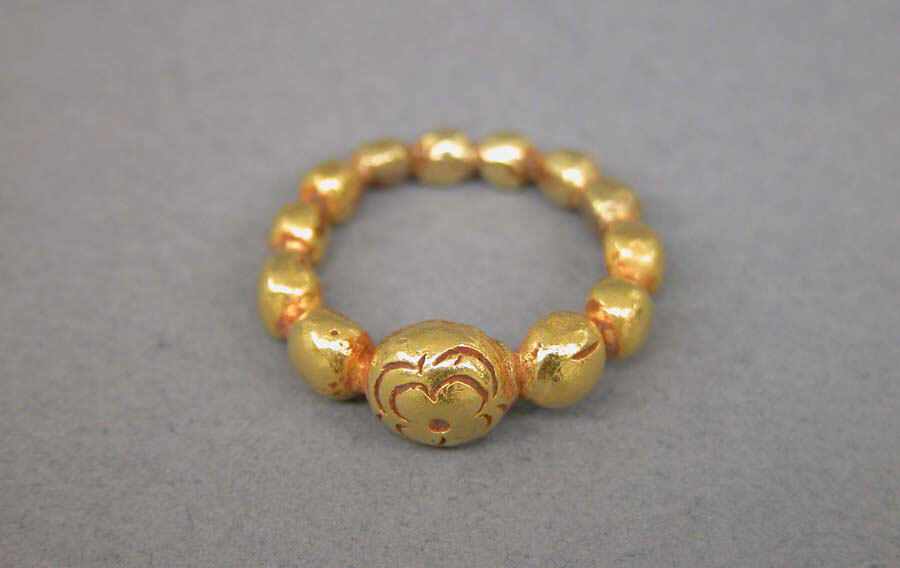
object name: ring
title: Ring Composed of 13 Beads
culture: indonesian, javanese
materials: gold